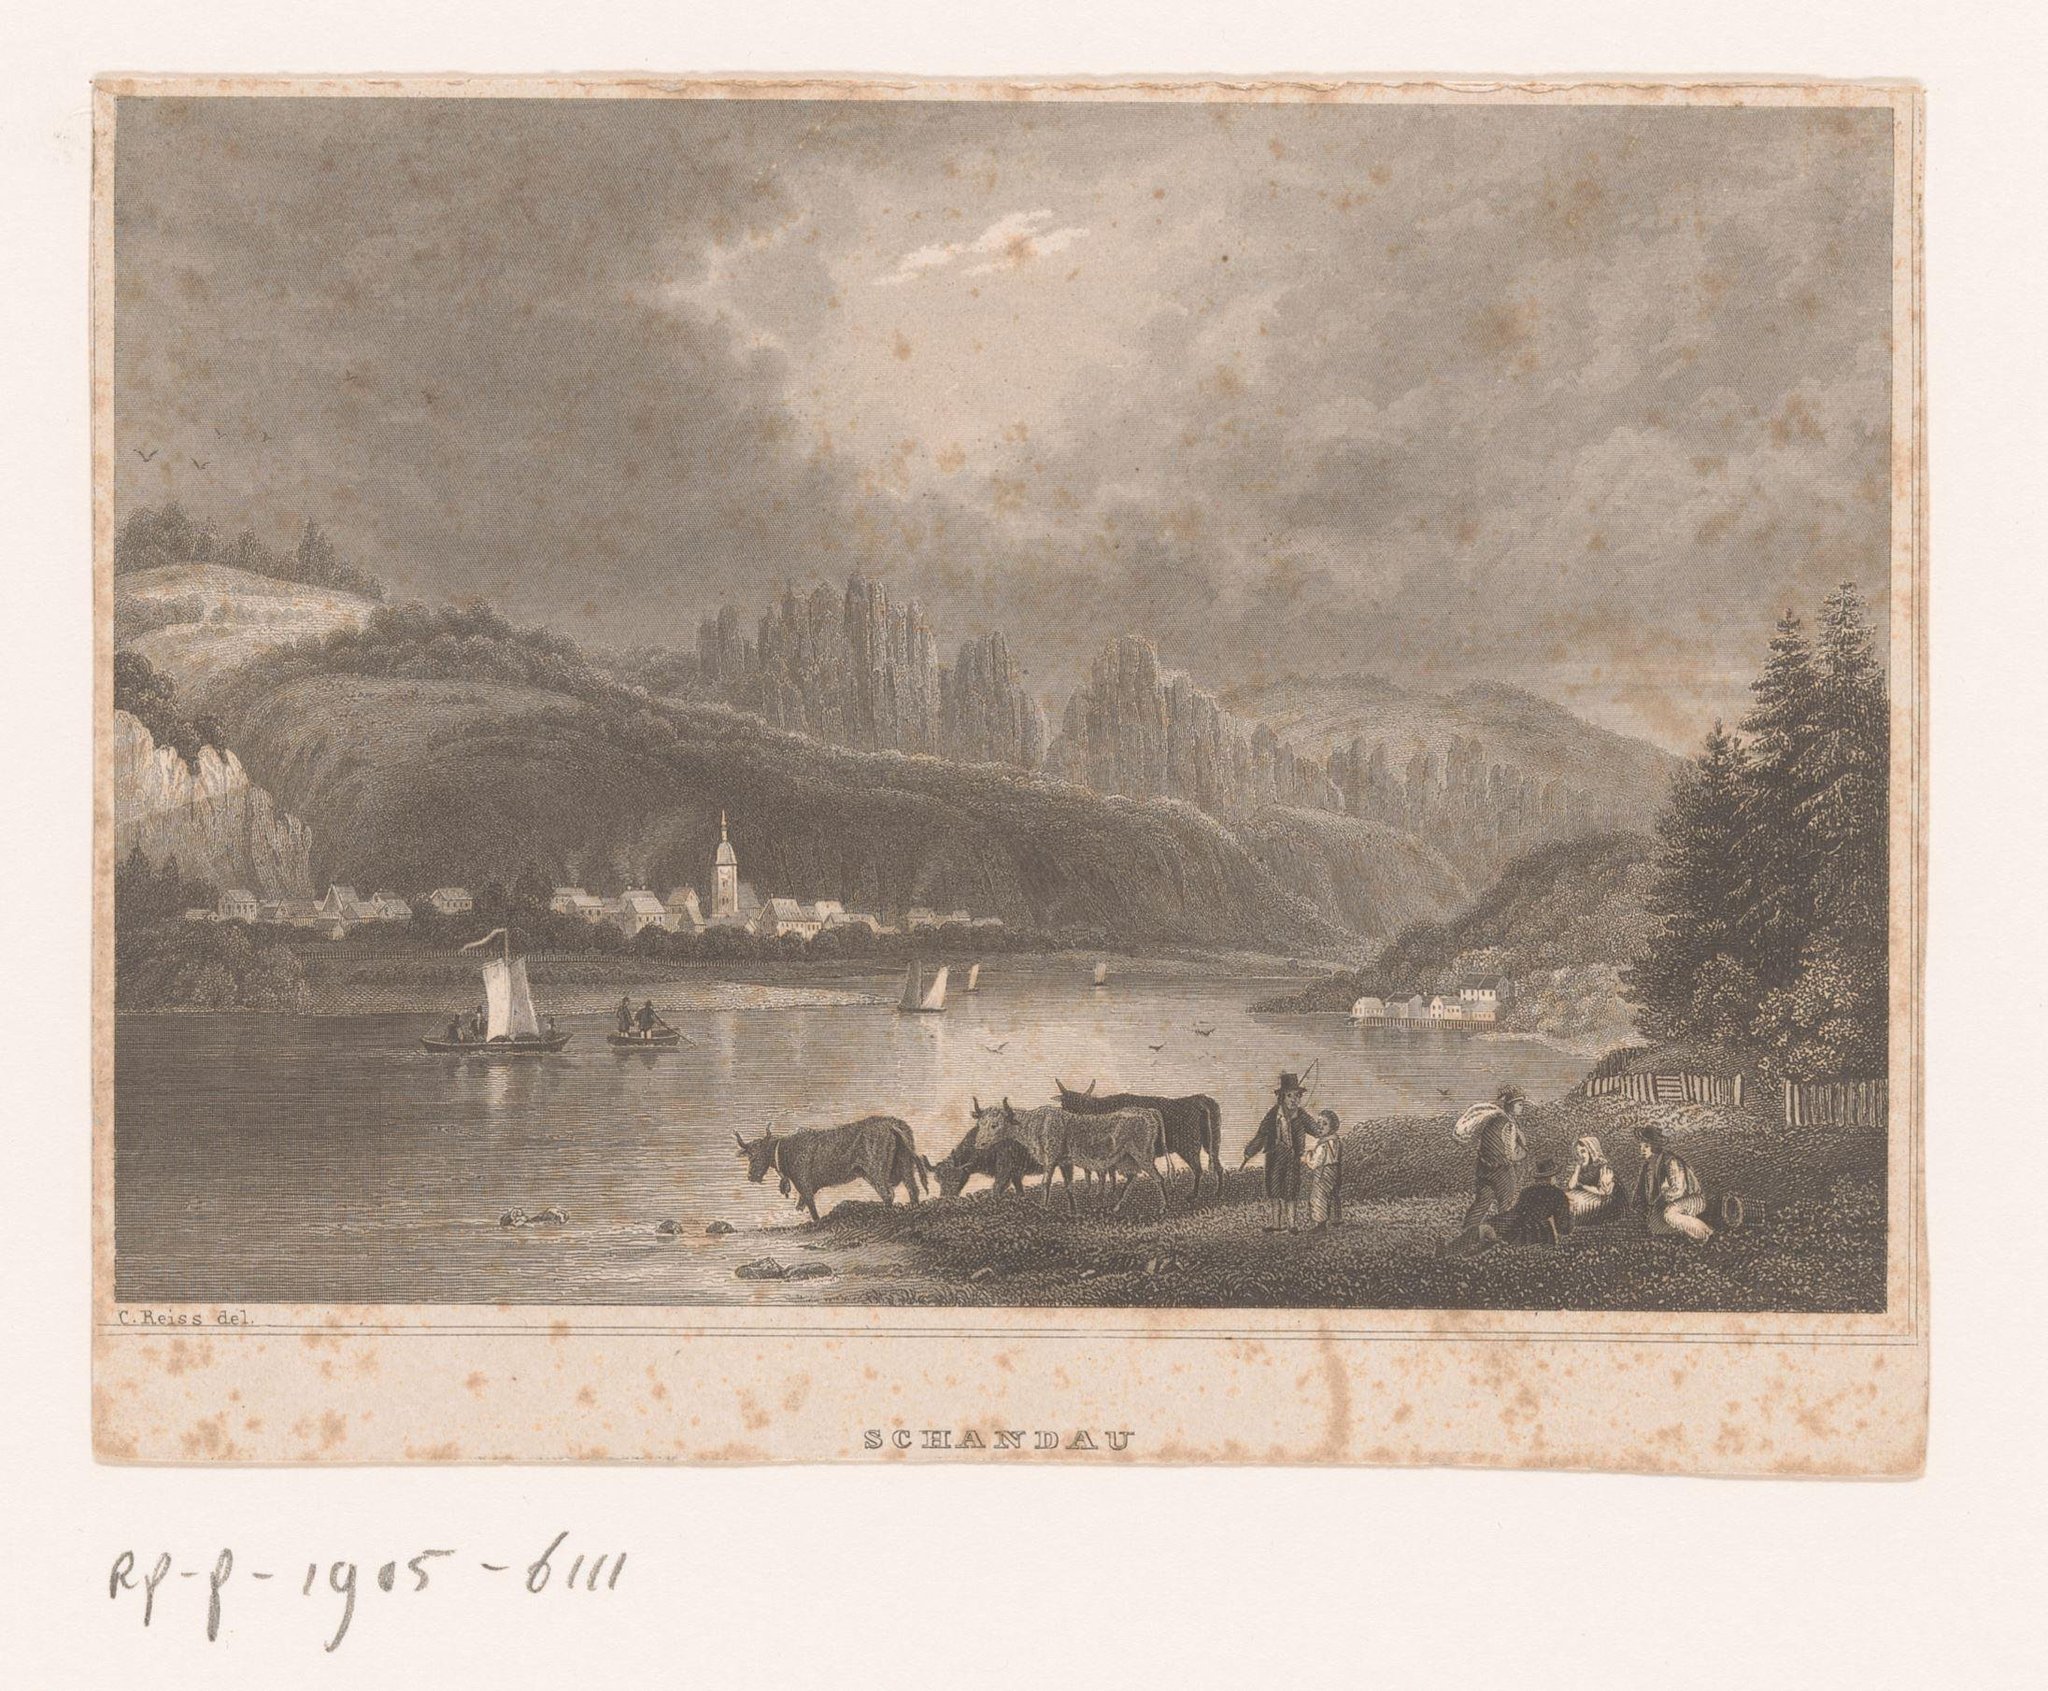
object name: print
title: Gezicht op de Schrammsteine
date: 1800-1899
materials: paper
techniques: engraving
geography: germany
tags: landscapes with waters, waterscapes, seascapes (in the temperate zone), mountains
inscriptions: collector's mark: Lugt 2228